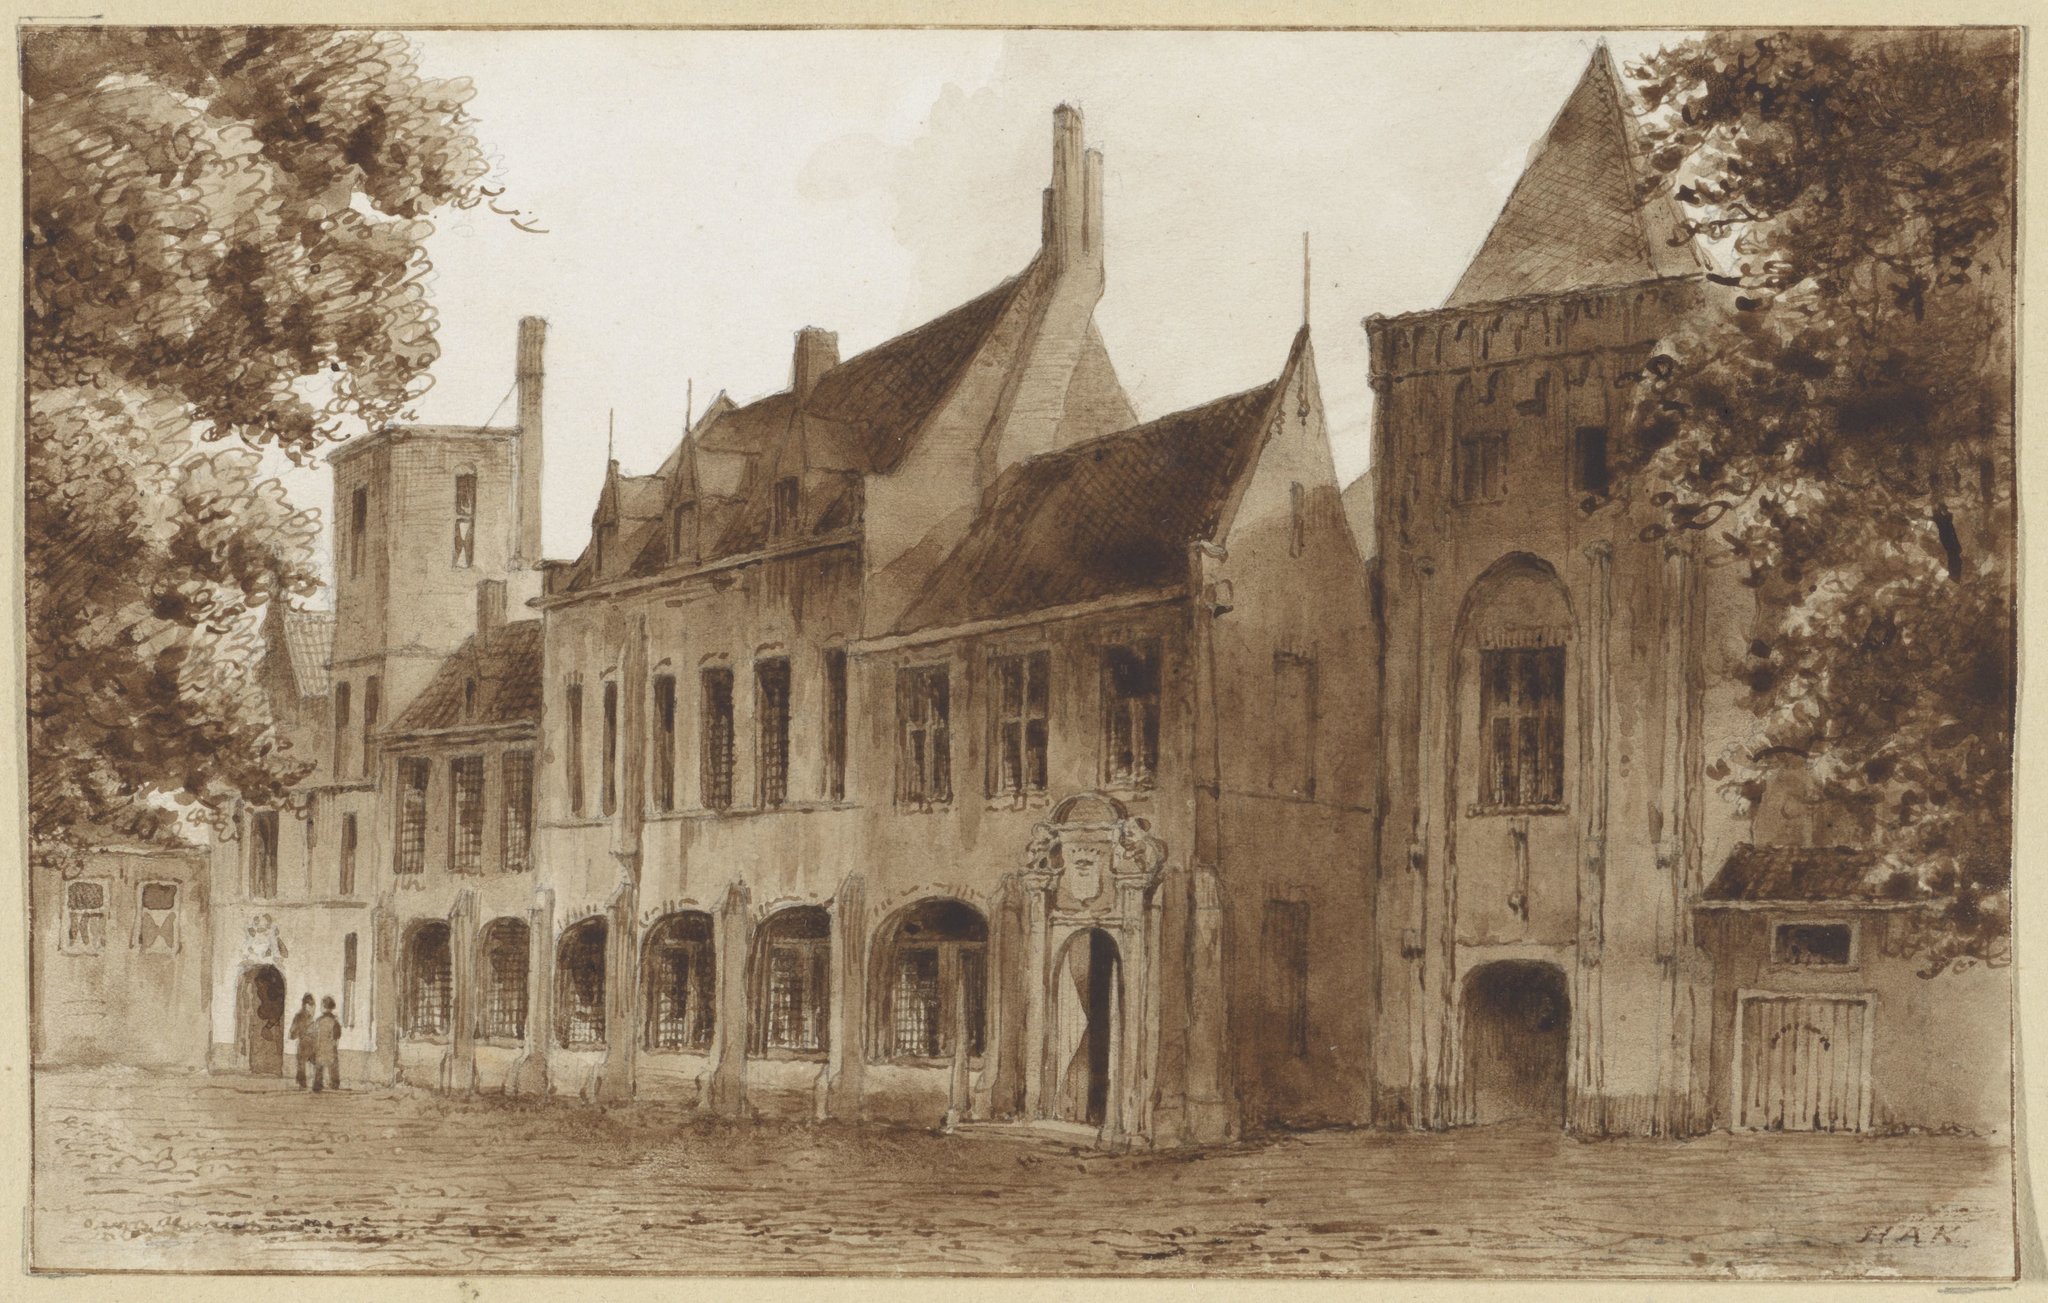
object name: drawing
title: Abdij te Middelburg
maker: hendrik abraham klinkhamer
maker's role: draughtsman, painter, print maker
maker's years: 1810-1872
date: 1851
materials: ink, paper, pencil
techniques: brush, pen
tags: abbey, monastery, convent ~ roman catholic church, middelburg